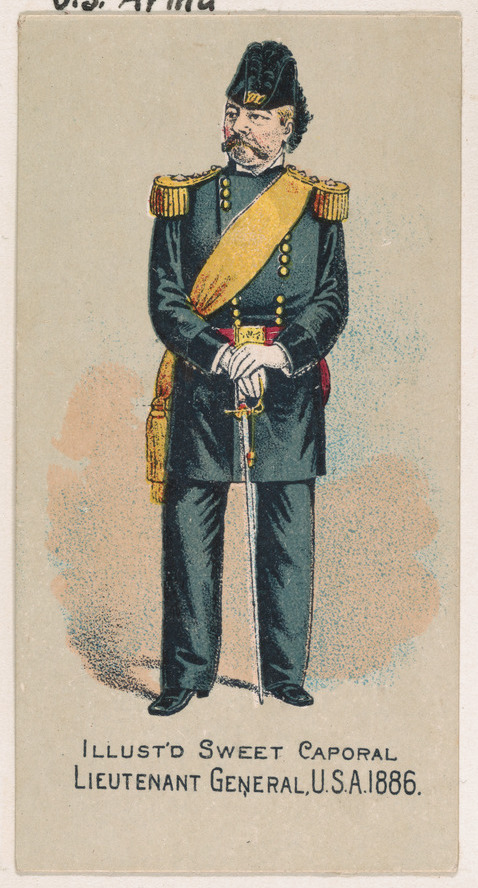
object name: print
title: Lieutenant General, United States Army, 1886, from the Military Series (N224) issued by Kinney Tobacco Company to promote Sweet Caporal Cigarettes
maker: kinney brothers tobacco company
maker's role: publisher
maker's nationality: american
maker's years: 1869-2011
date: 1888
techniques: color lithograph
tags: men,generals